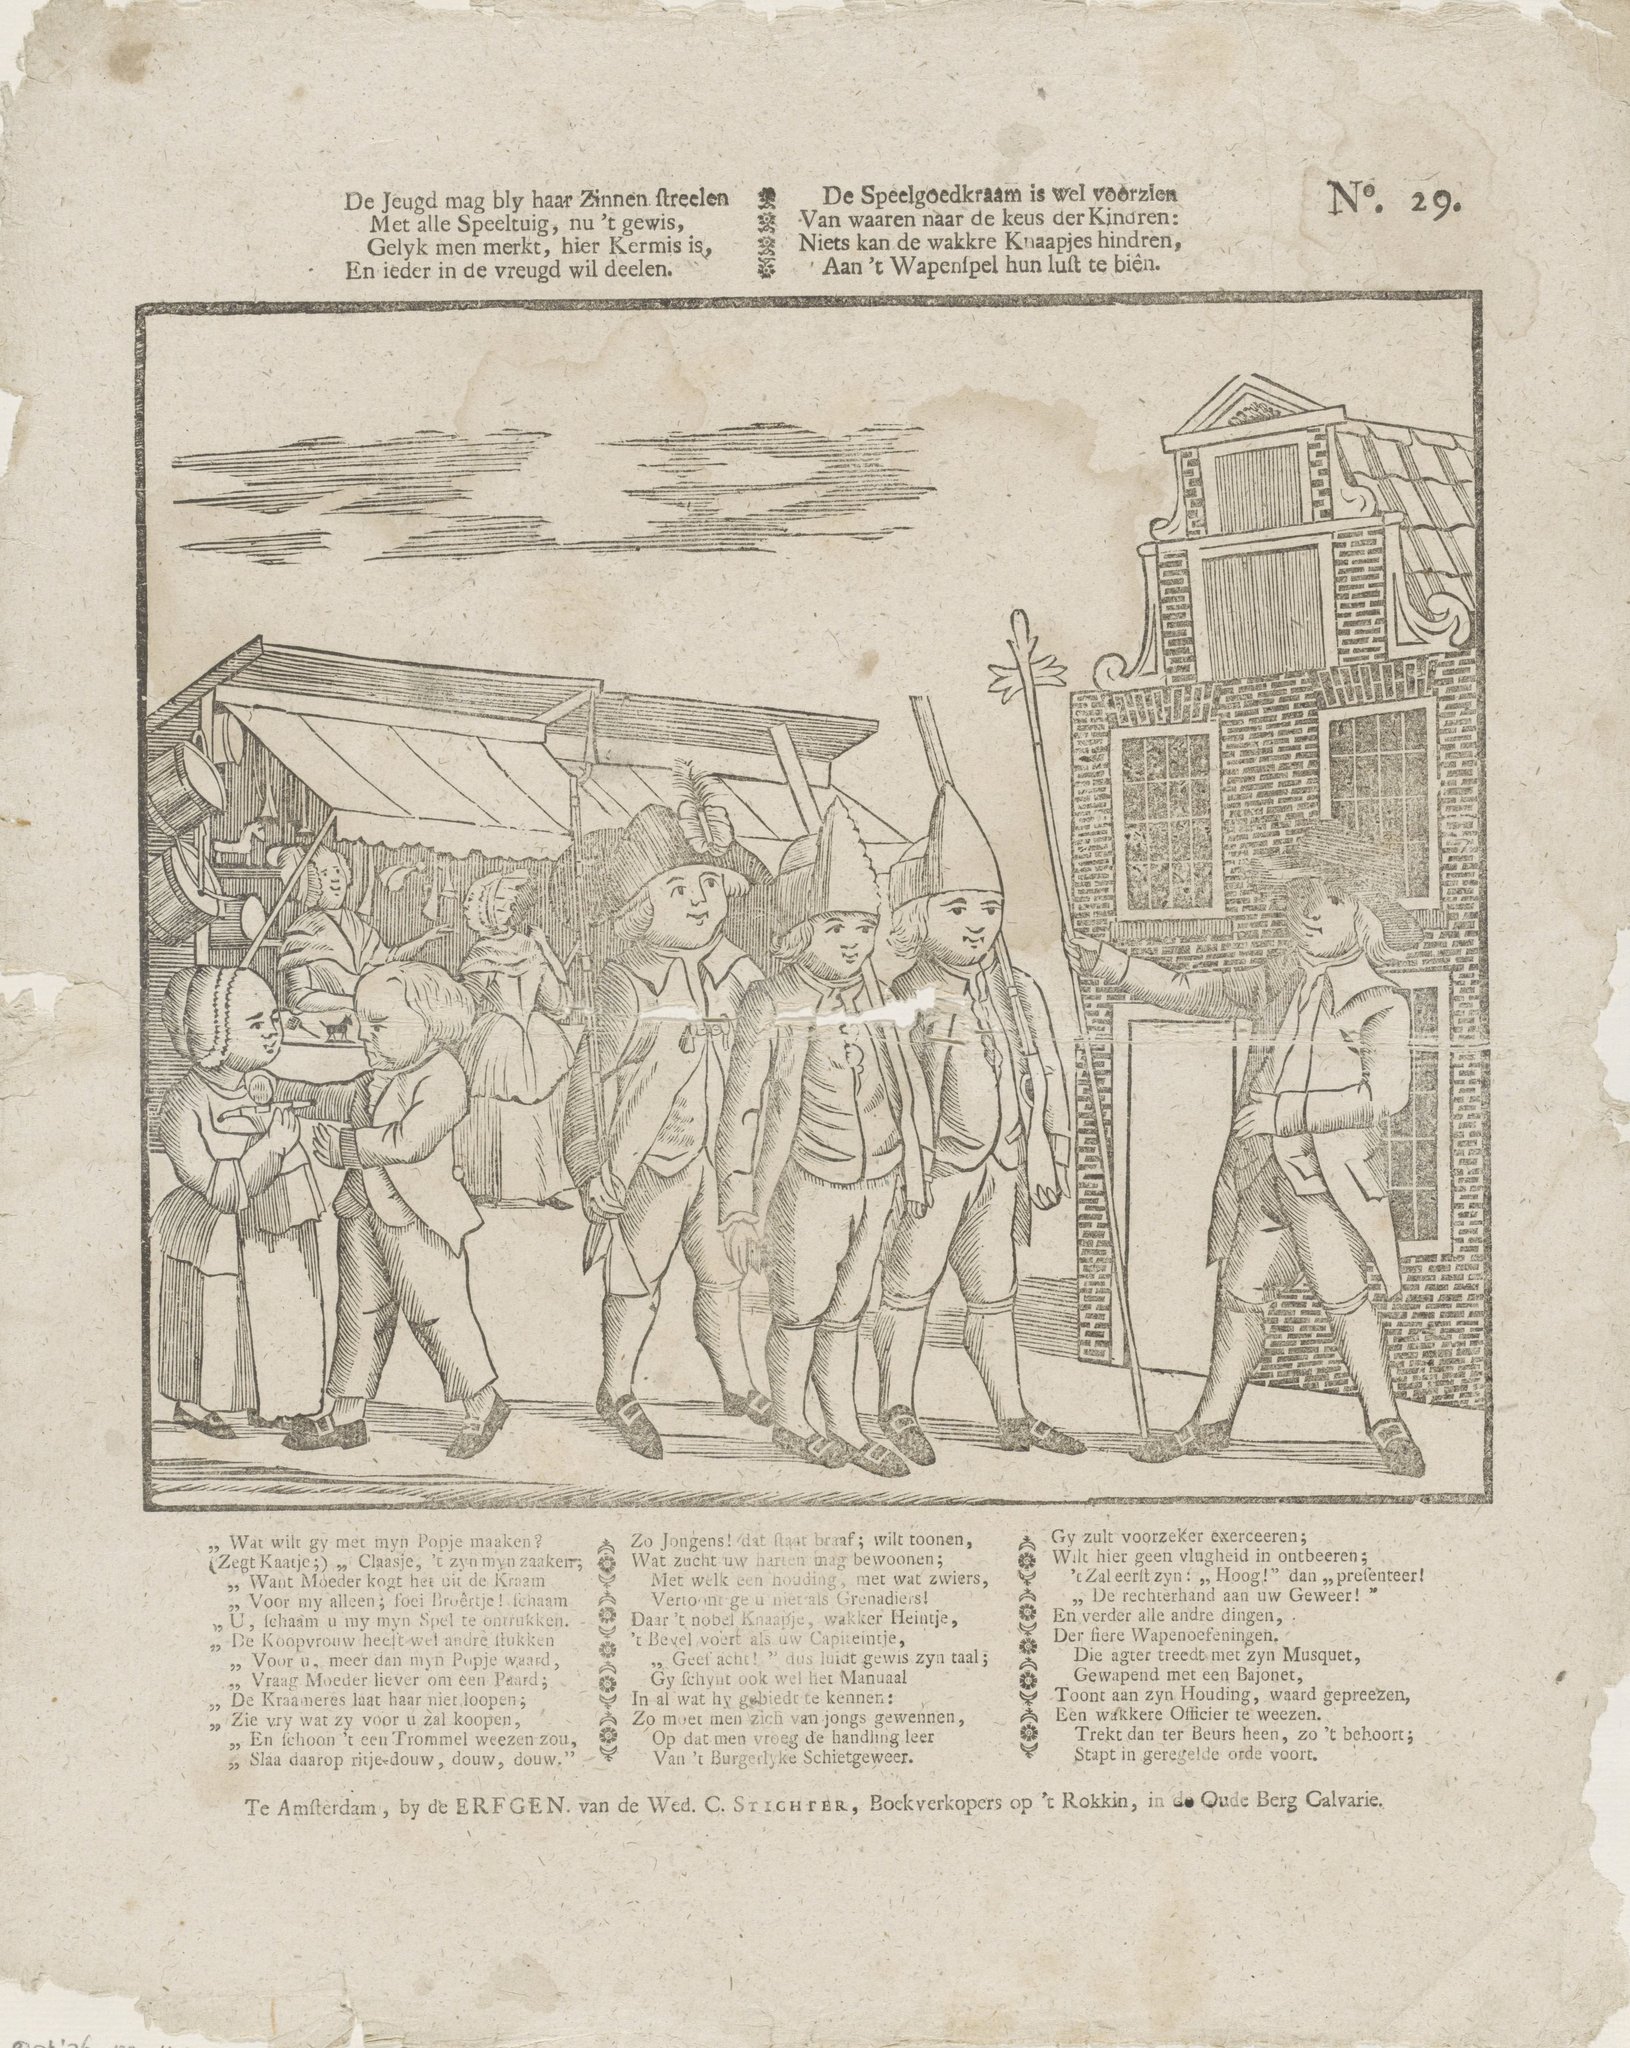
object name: print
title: De jeugd mag bly met haar zinnen streelen / Met alle speeltuig, nu 't gewis [(...)]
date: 1715-1813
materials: paper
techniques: letterpress printing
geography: amsterdam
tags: fancy fair, pleasure fair and circus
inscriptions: collector's mark: Lugt 2760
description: Blad met een grote voorstelling van een groepje jongens op de kermis. Onder de afbeelding een vers in drie kolommen. Genummerd rechtsboven: No. 29.